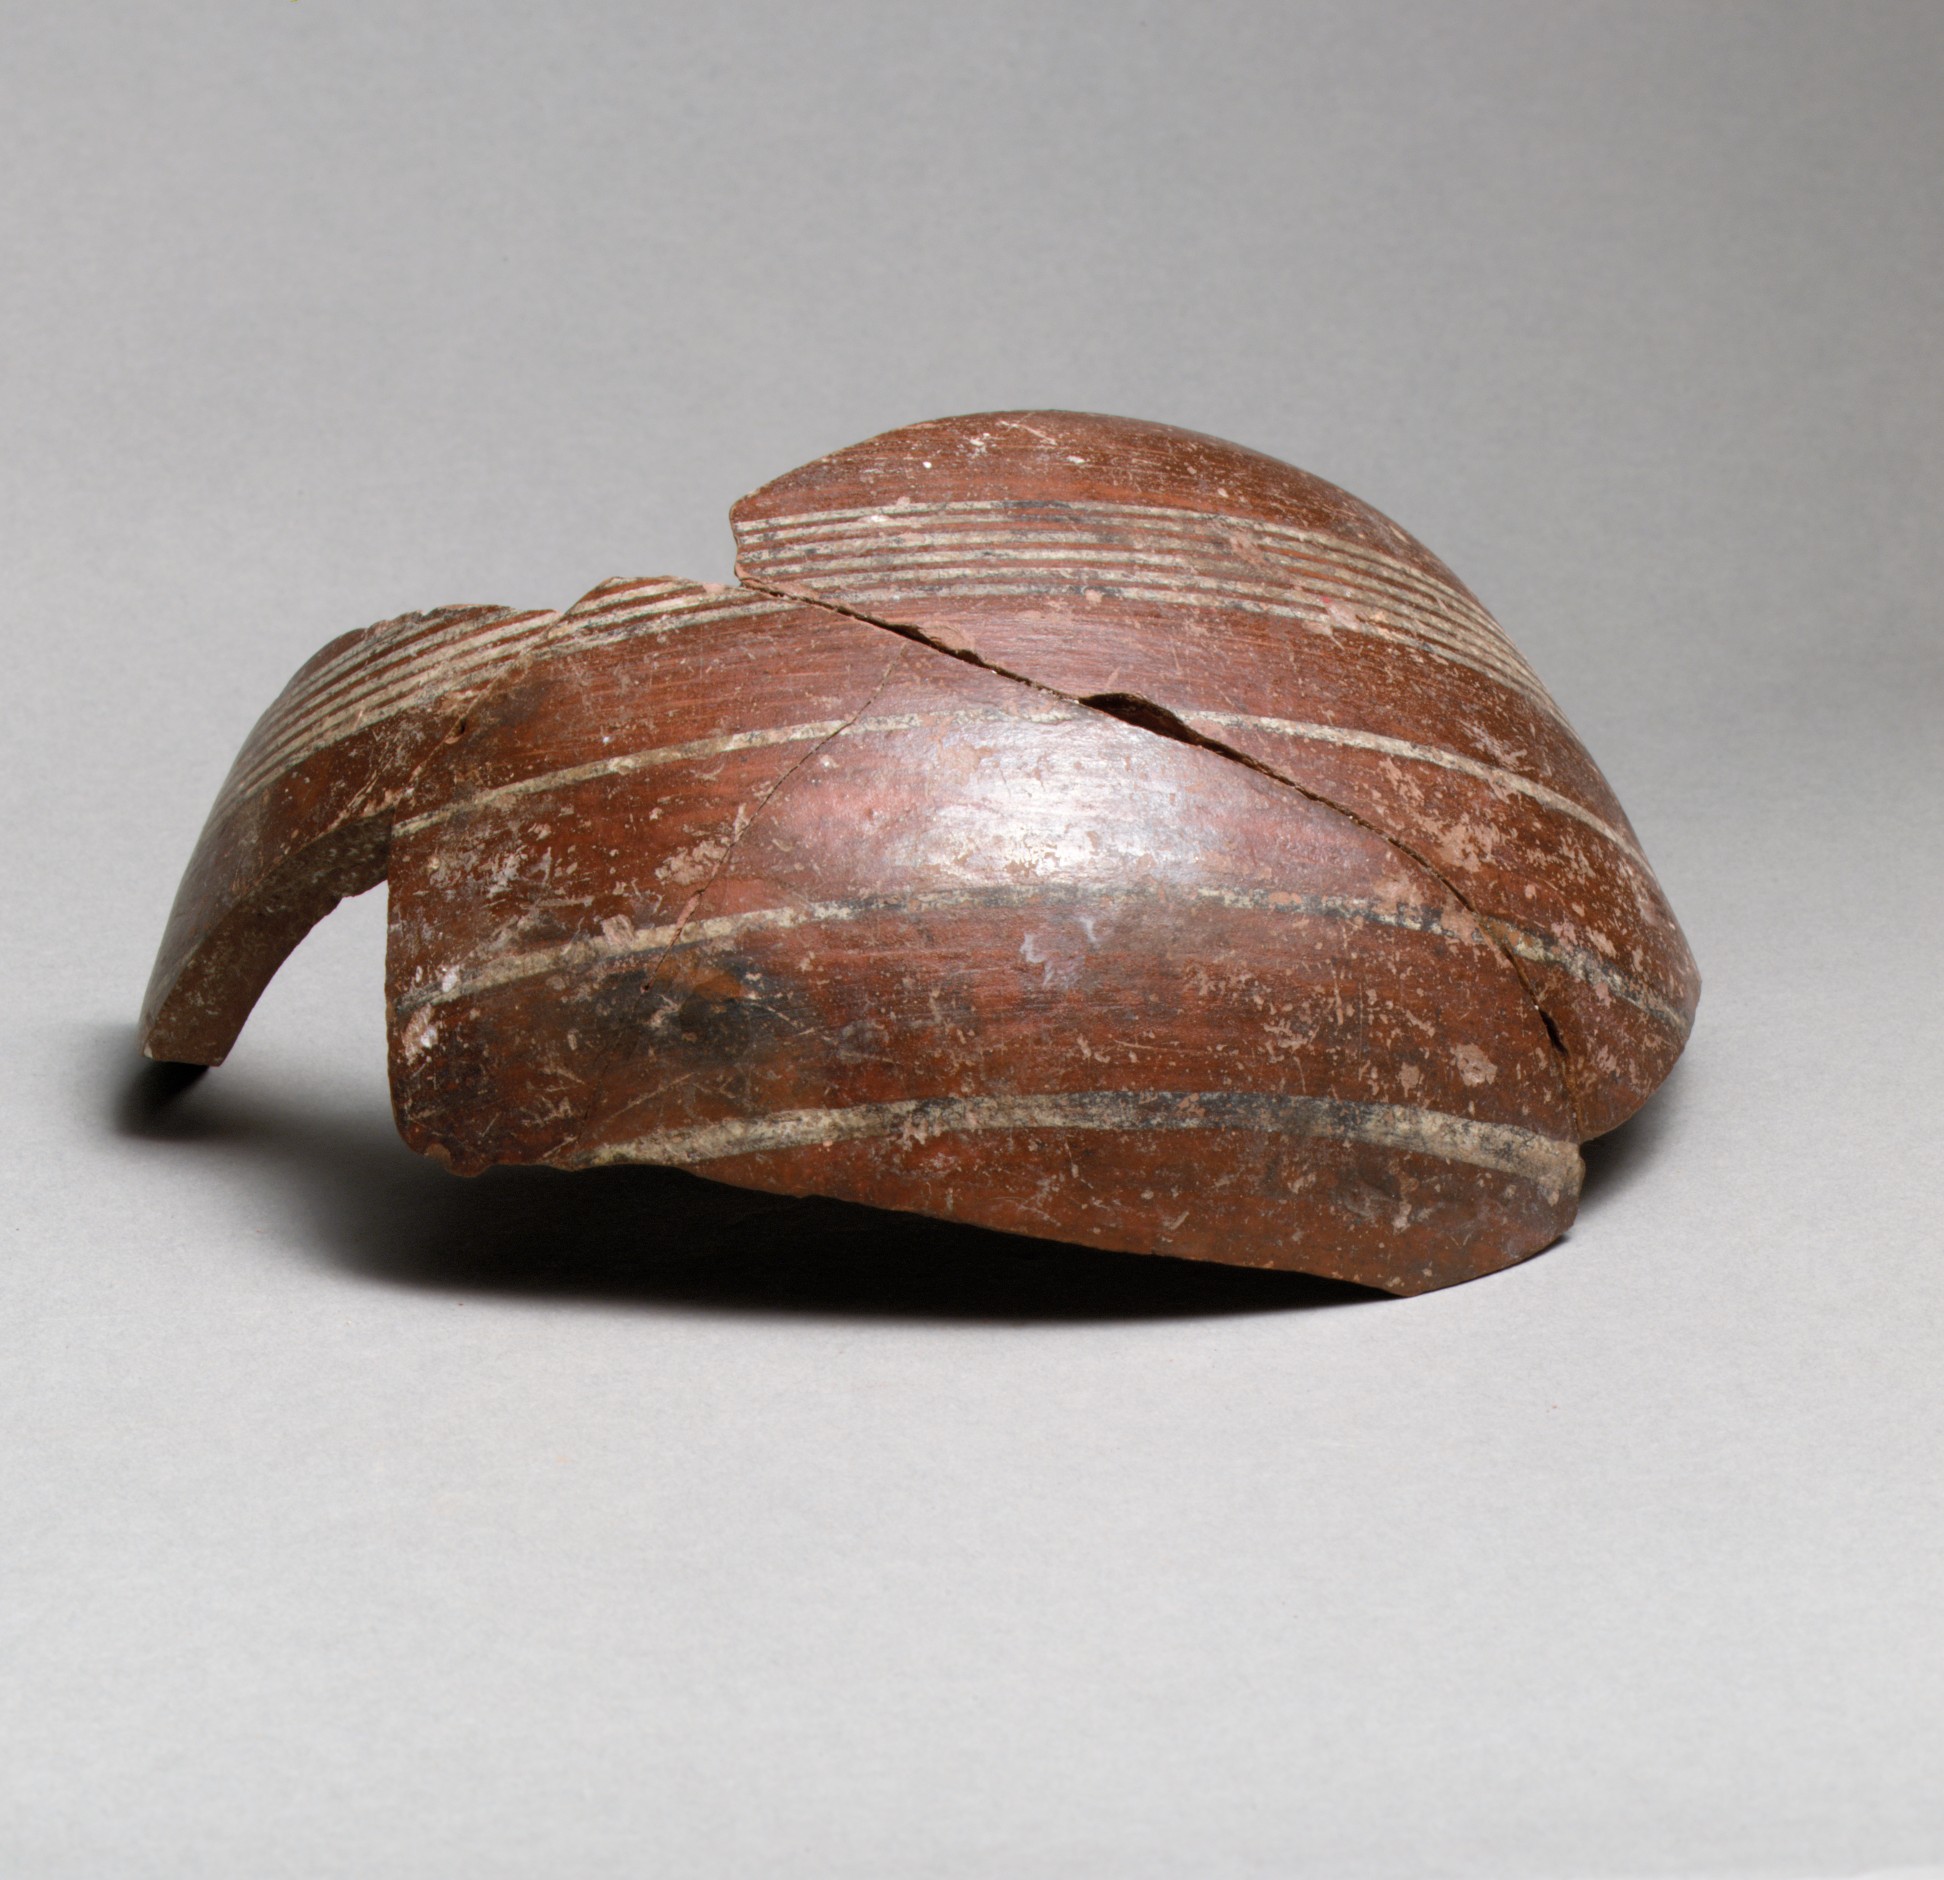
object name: vase fragment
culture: greek or lydian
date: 900-30 BCE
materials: terracotta